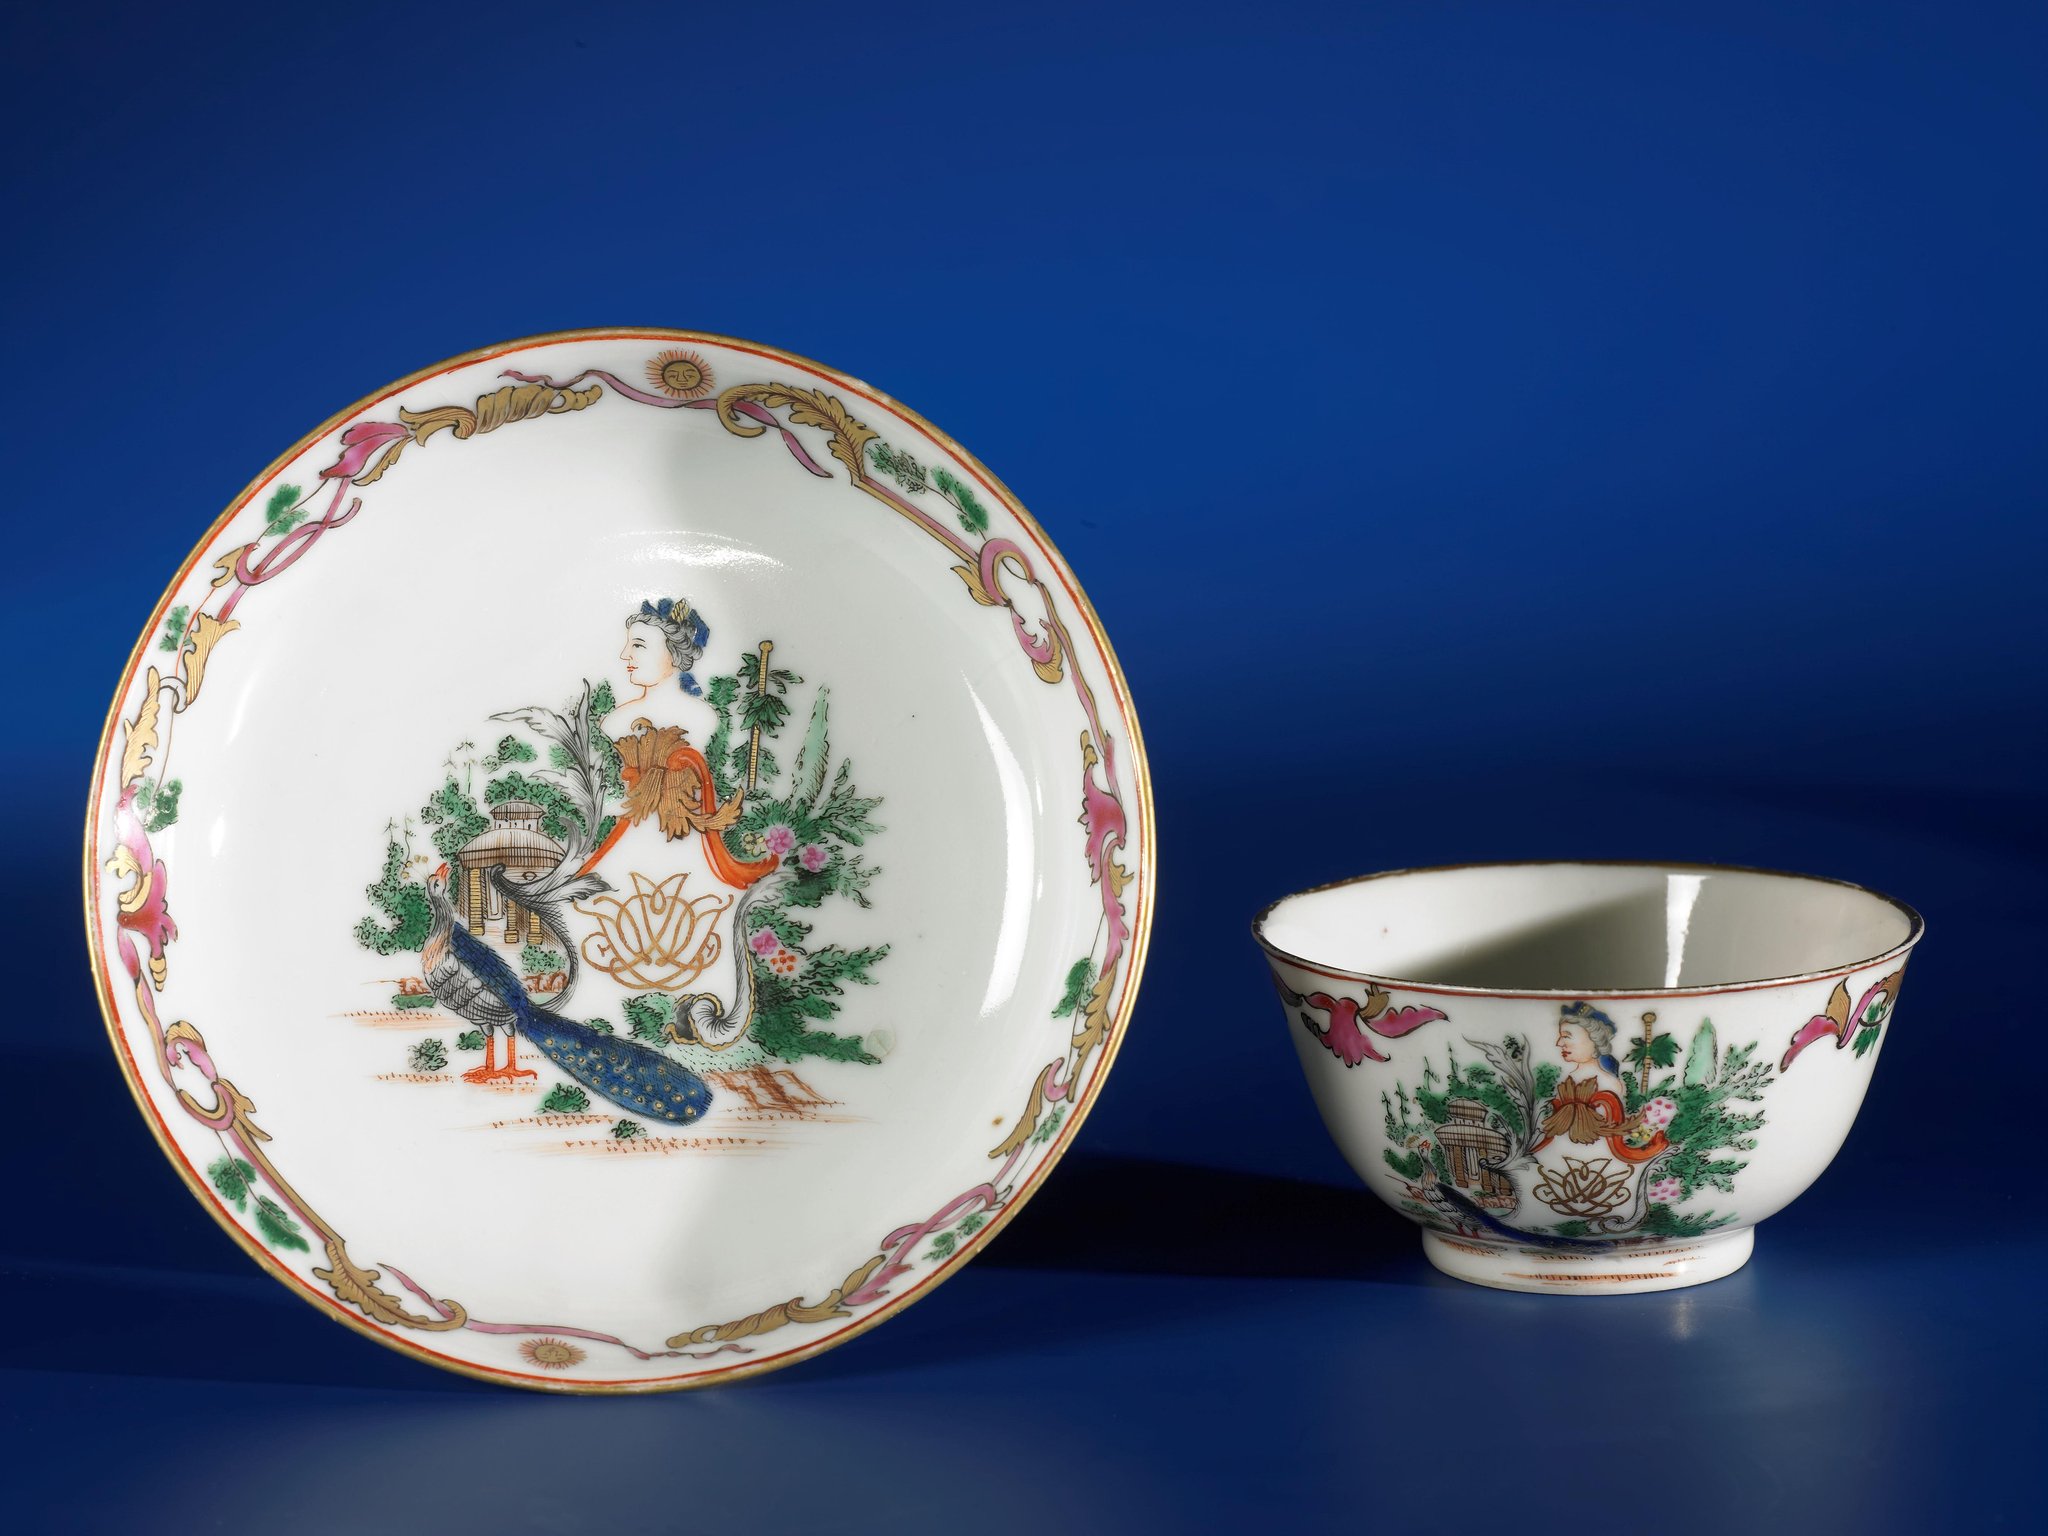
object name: platter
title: Saucer with an elaboratly decorated monogram 'IDF'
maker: Anonymous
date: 1750-1774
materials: glaze, gold, paint, porcelain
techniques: firing, gilding, turning, vitrification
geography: china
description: Wijd uitlopende kop en schotel op een voetring, gedecoreerd in emailkleuren en goud. Centraal een monogram met de initialen IDF. Daar omheen een landschap met bomen, bloemen en een pauw en een Grieks uitziend rond tempeltje. Bovenaan een buste van een Grieks uitziende dame. Op de rand een decoratief patroon met boven en onder een zonnetje.